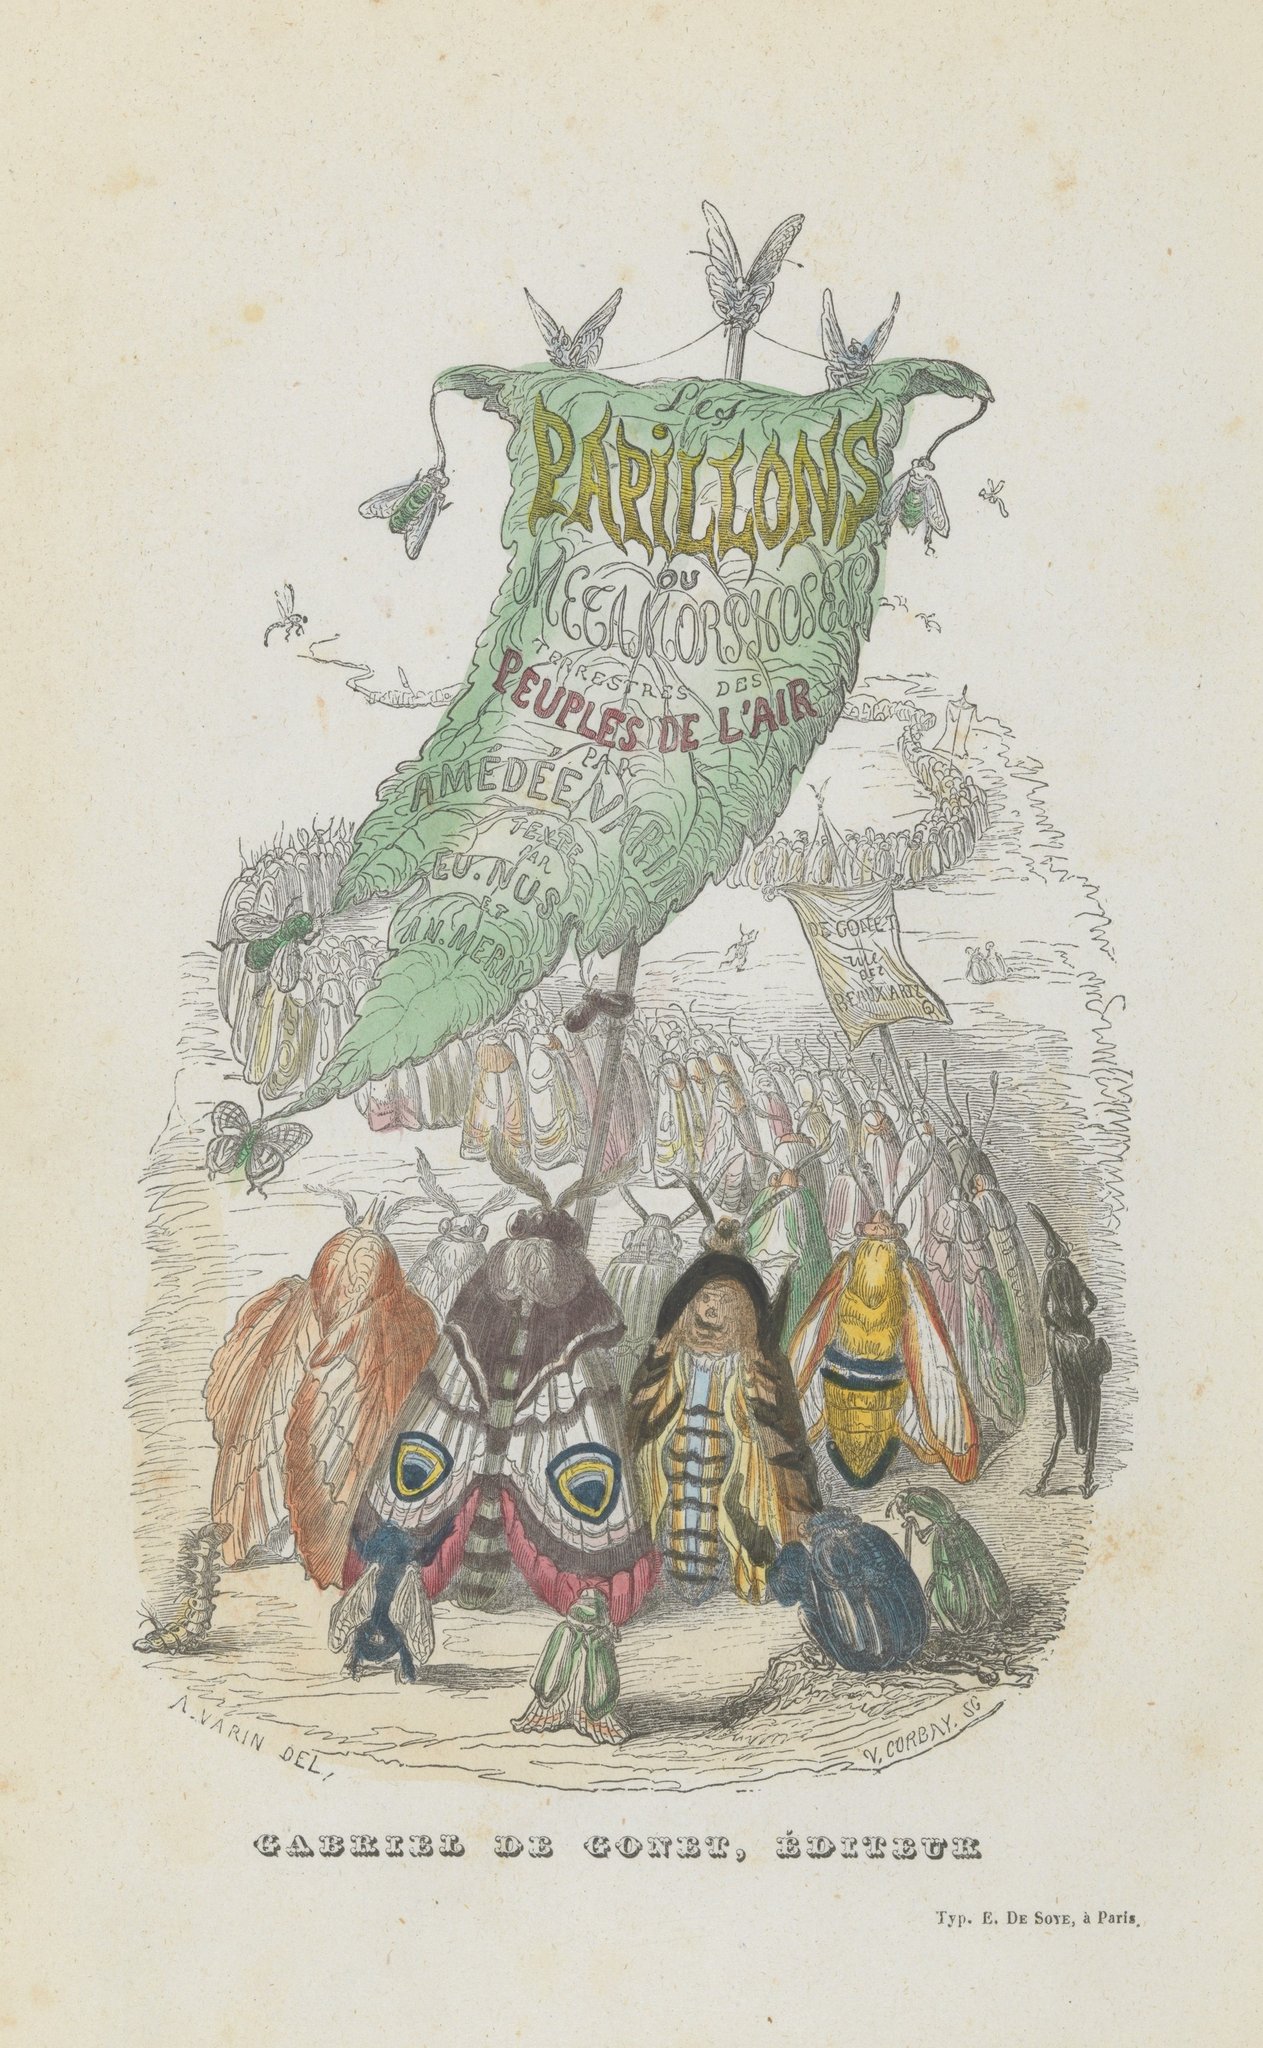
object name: book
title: Les Papillons: Métamorphoses terrestres des peuples de l'air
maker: amédée varin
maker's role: illustrator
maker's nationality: french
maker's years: 1818-1883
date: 1852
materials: steel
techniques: engraving, hand coloring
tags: butterflies